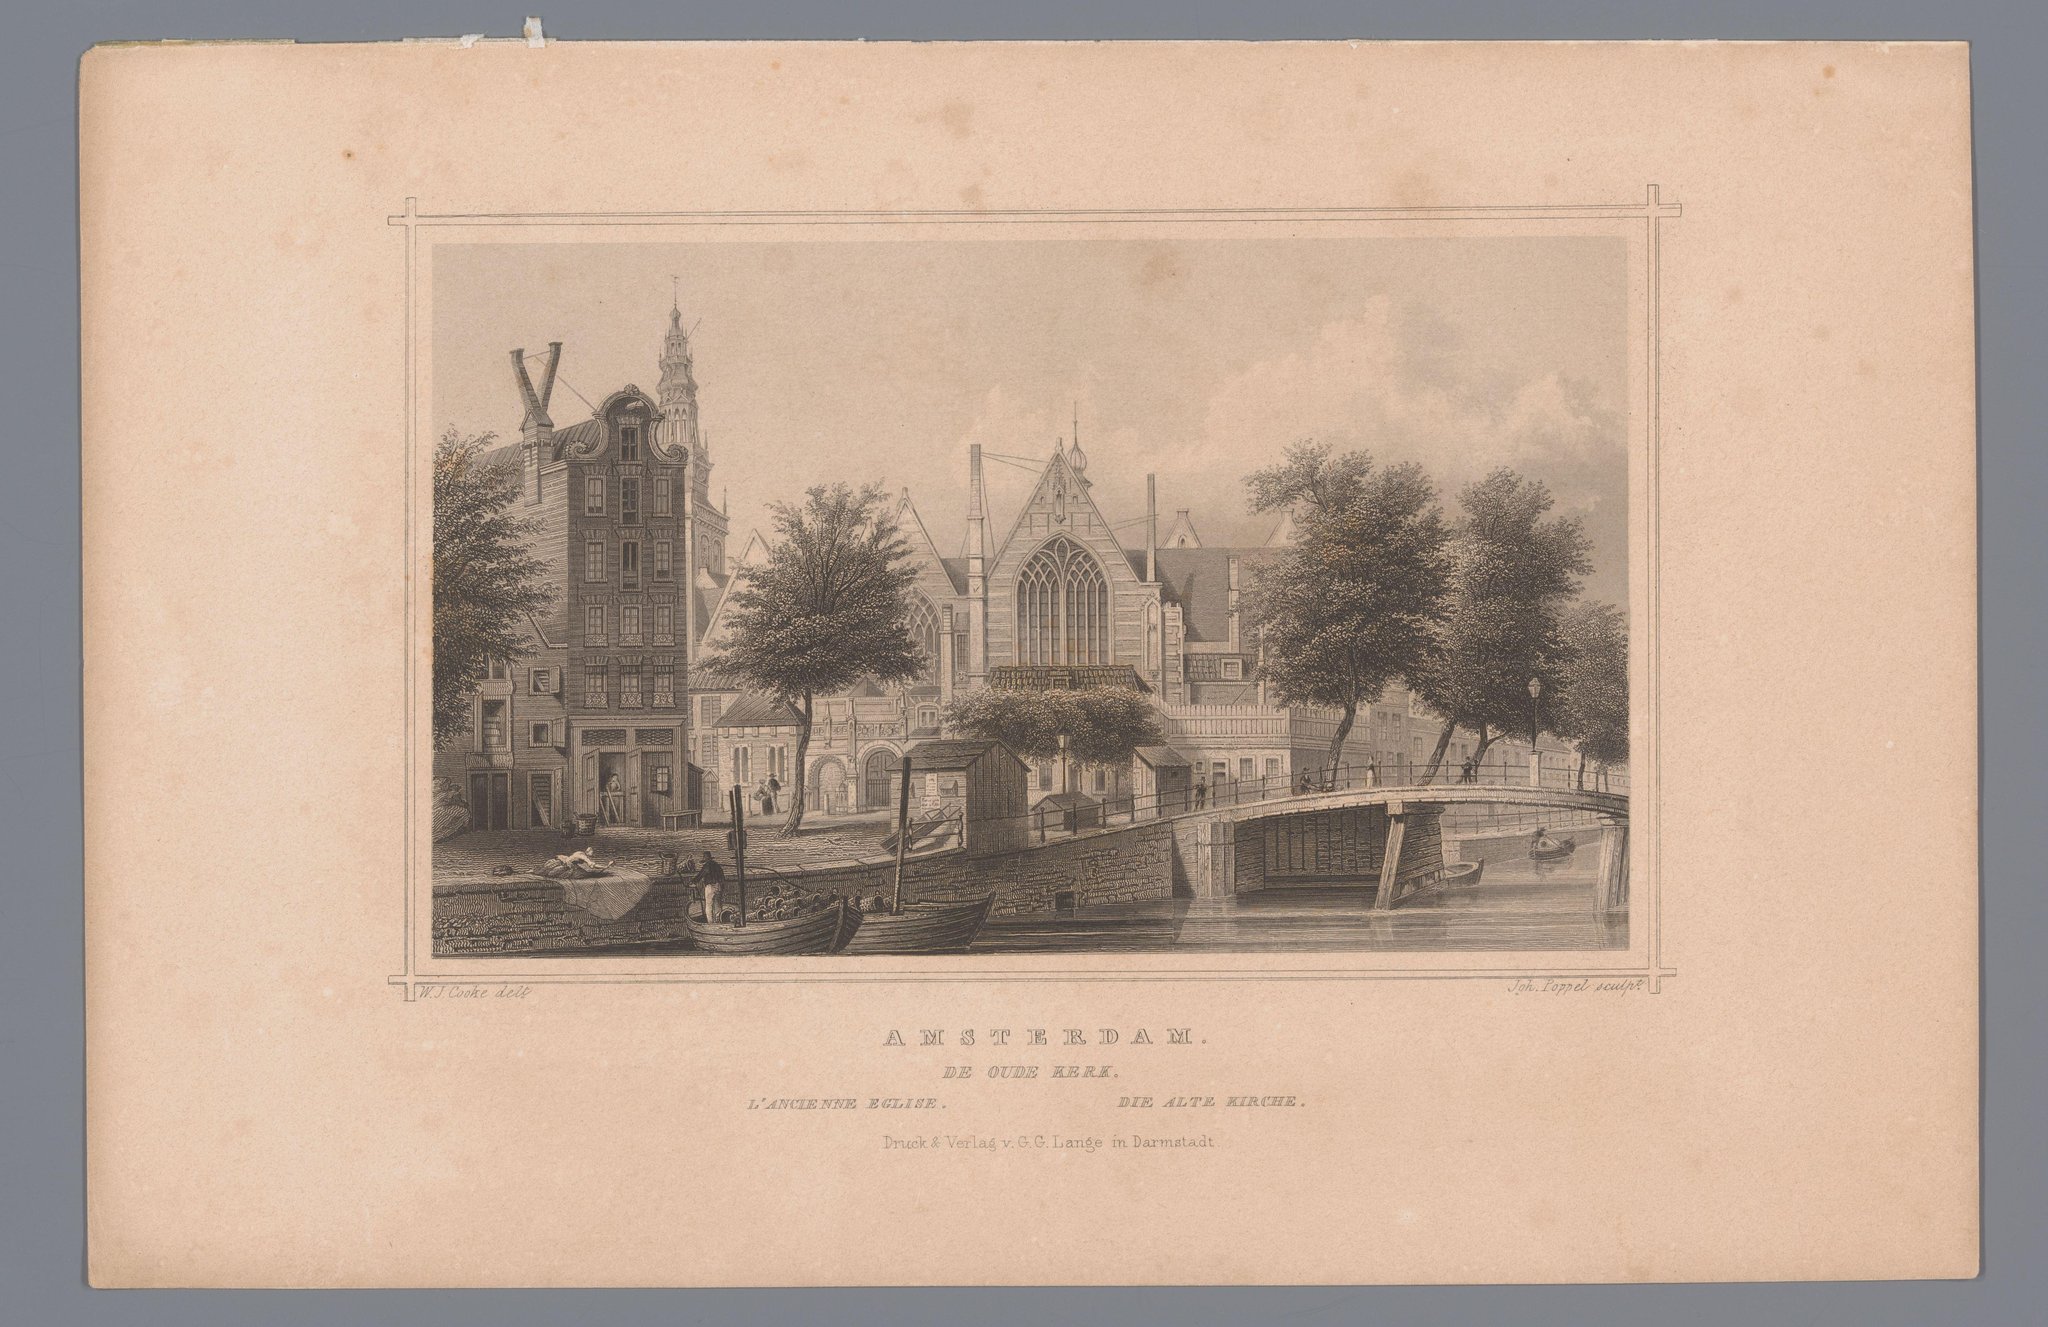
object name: print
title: Gezicht op de Oude Kerk te Amsterdam vanaf de Oudezijds Voorburgwal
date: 1855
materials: paper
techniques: engraving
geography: darmstadt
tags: church (exterior), canals, waters (in city) (+ city(-scape) with figures, staffage)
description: Prent komt in een andere staat voor in: Terwen, Johannes Leonardus. Het Koningrijk der Nederlanden voorgesteld in eene reeks van naar de natuur geteekende schilderachtige gezigten. Gouda: G.B. van Goor, 1855, dl. 1. Mogelijk komt de prent ook in de huidige staat in drukken van dit boek voor.